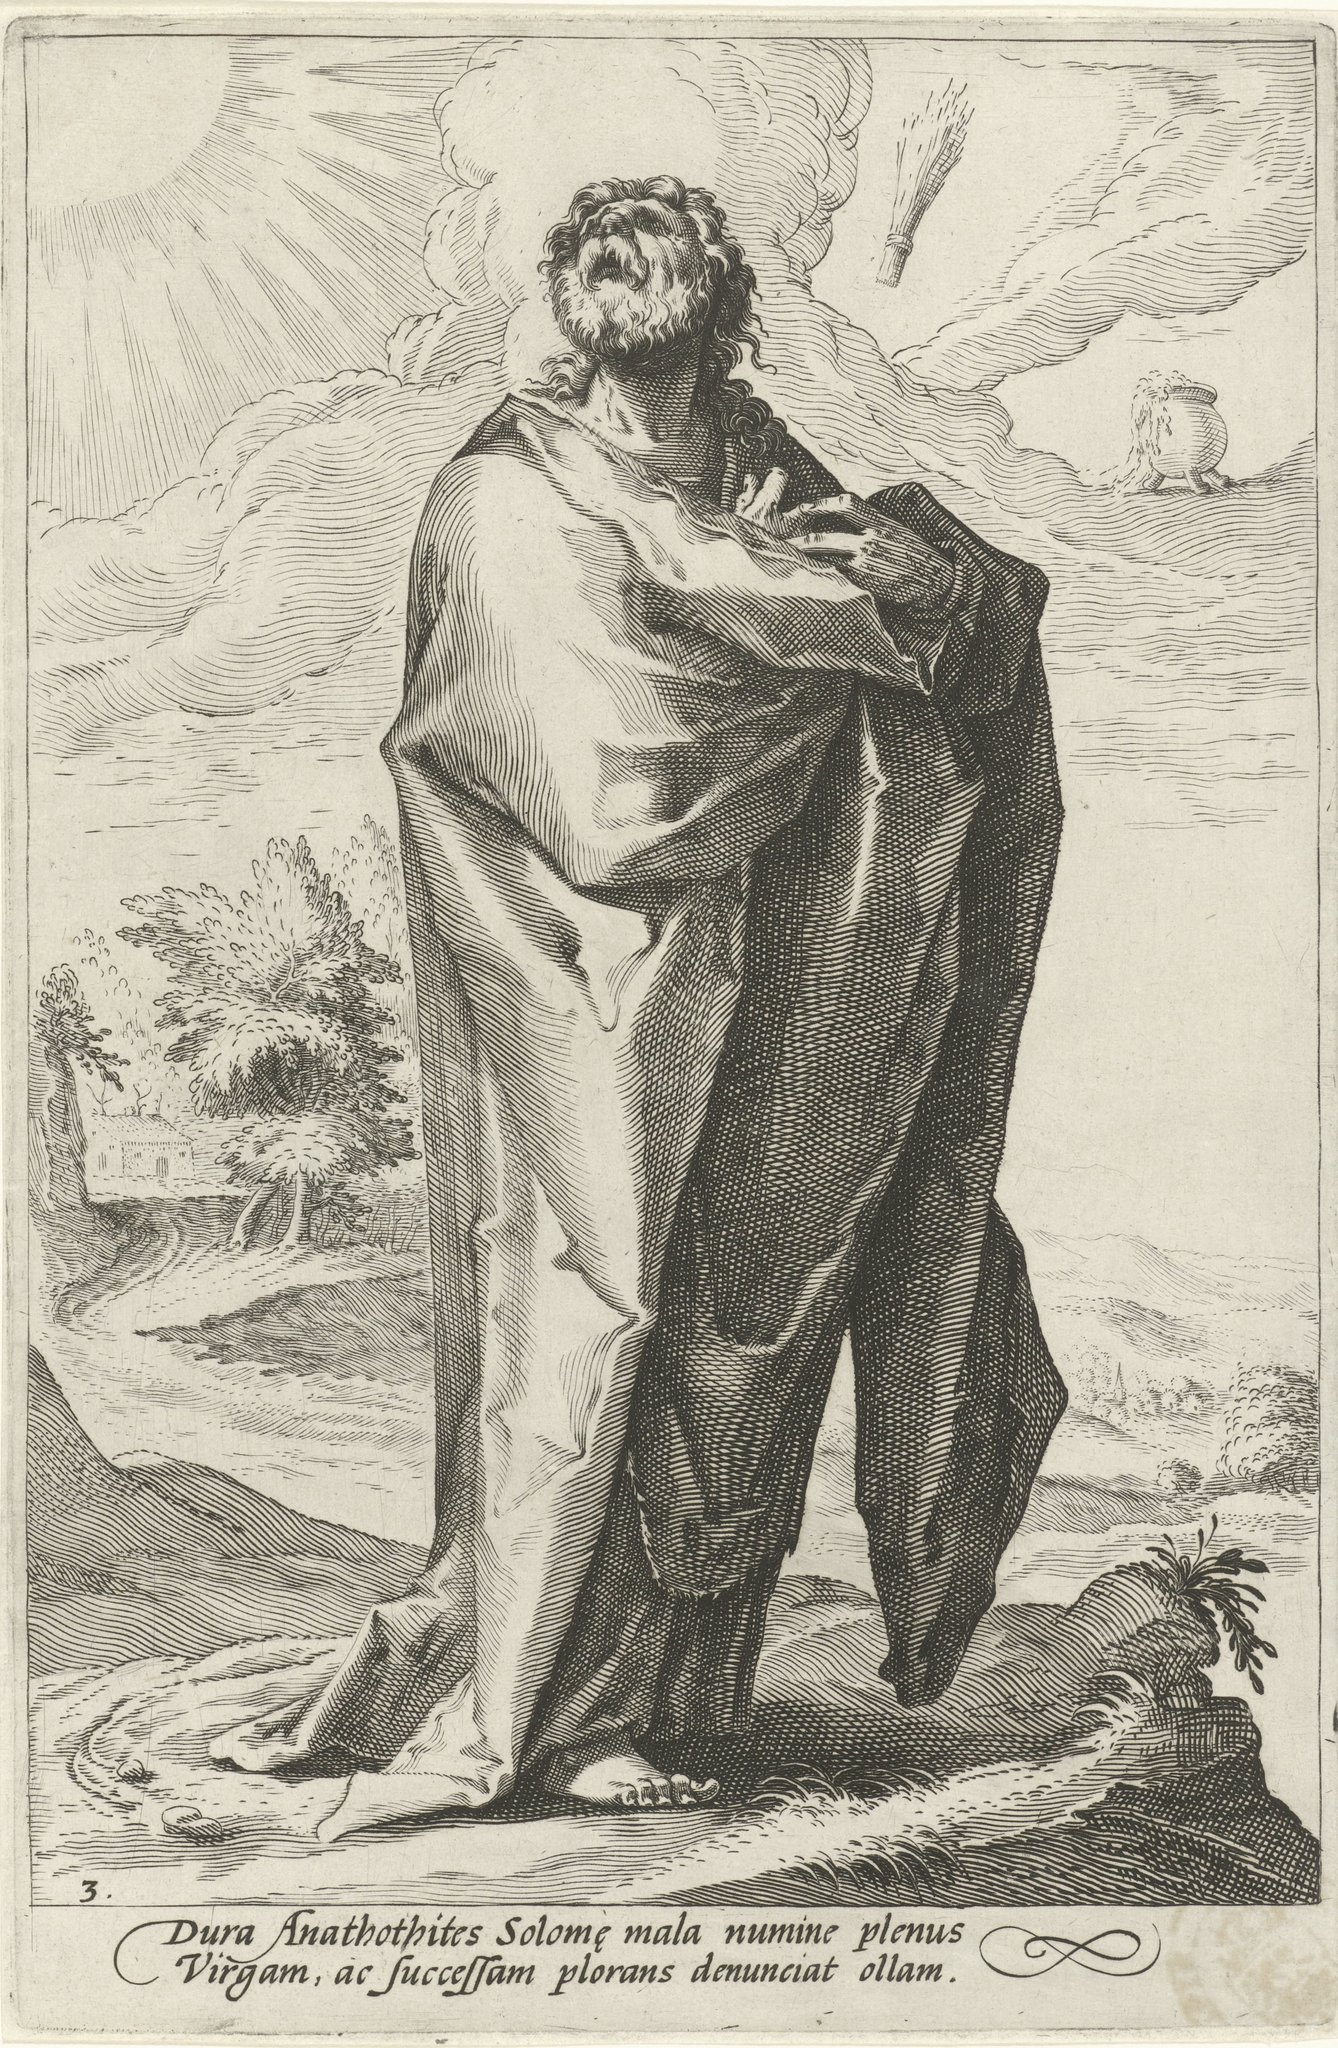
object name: print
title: Profeten van het Oude Testament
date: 1589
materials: paper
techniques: engraving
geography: haarlem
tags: jeremiah (not in biblical context); possible attributes: book or scroll, 'the seething pot'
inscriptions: collector's mark: Lugt 240